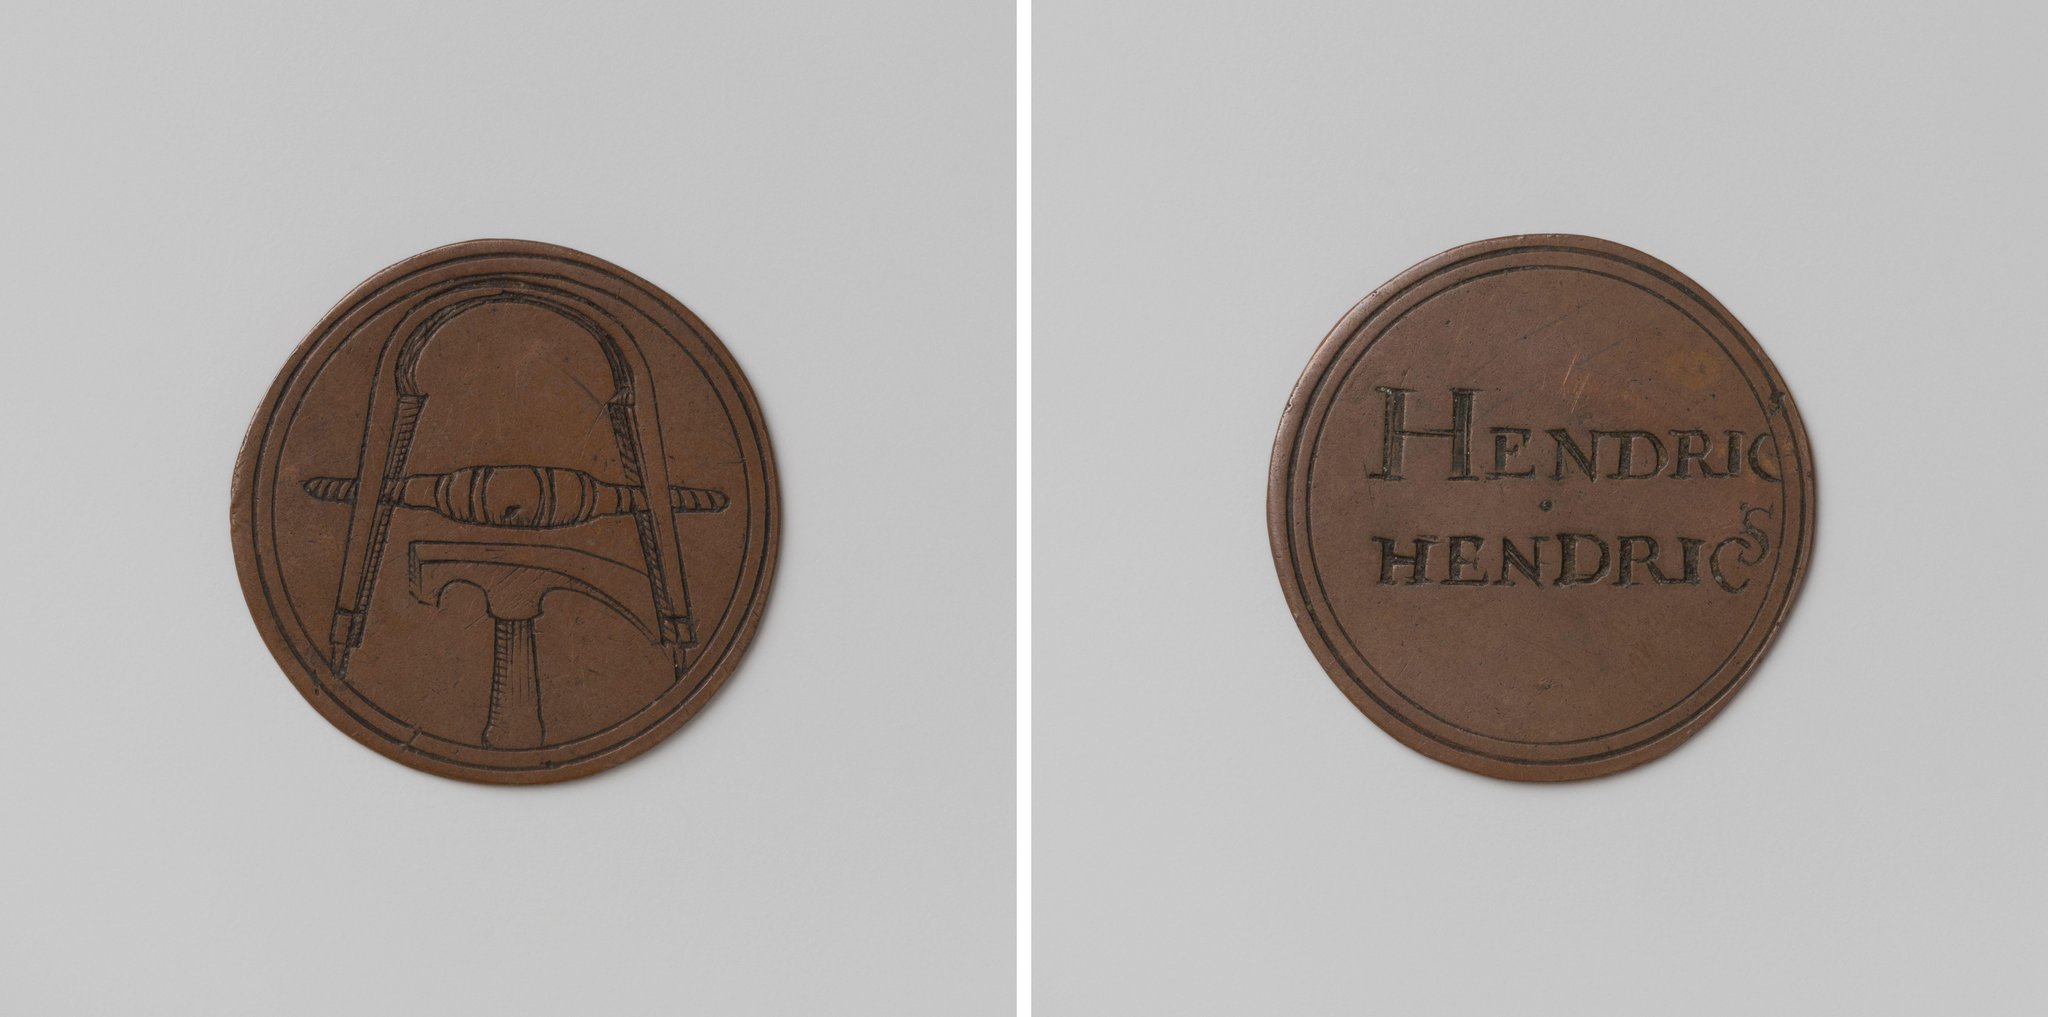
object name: medal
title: Kuipersgilde, gildepenning van Hendric Hendrics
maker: Anonymous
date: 1600-1750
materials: copper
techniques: engraving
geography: netherlands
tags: hendric hendrics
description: Koperen penning. Voorzijde: kuipersdissel boven kuipershamer. Keerzijde: opschrift.